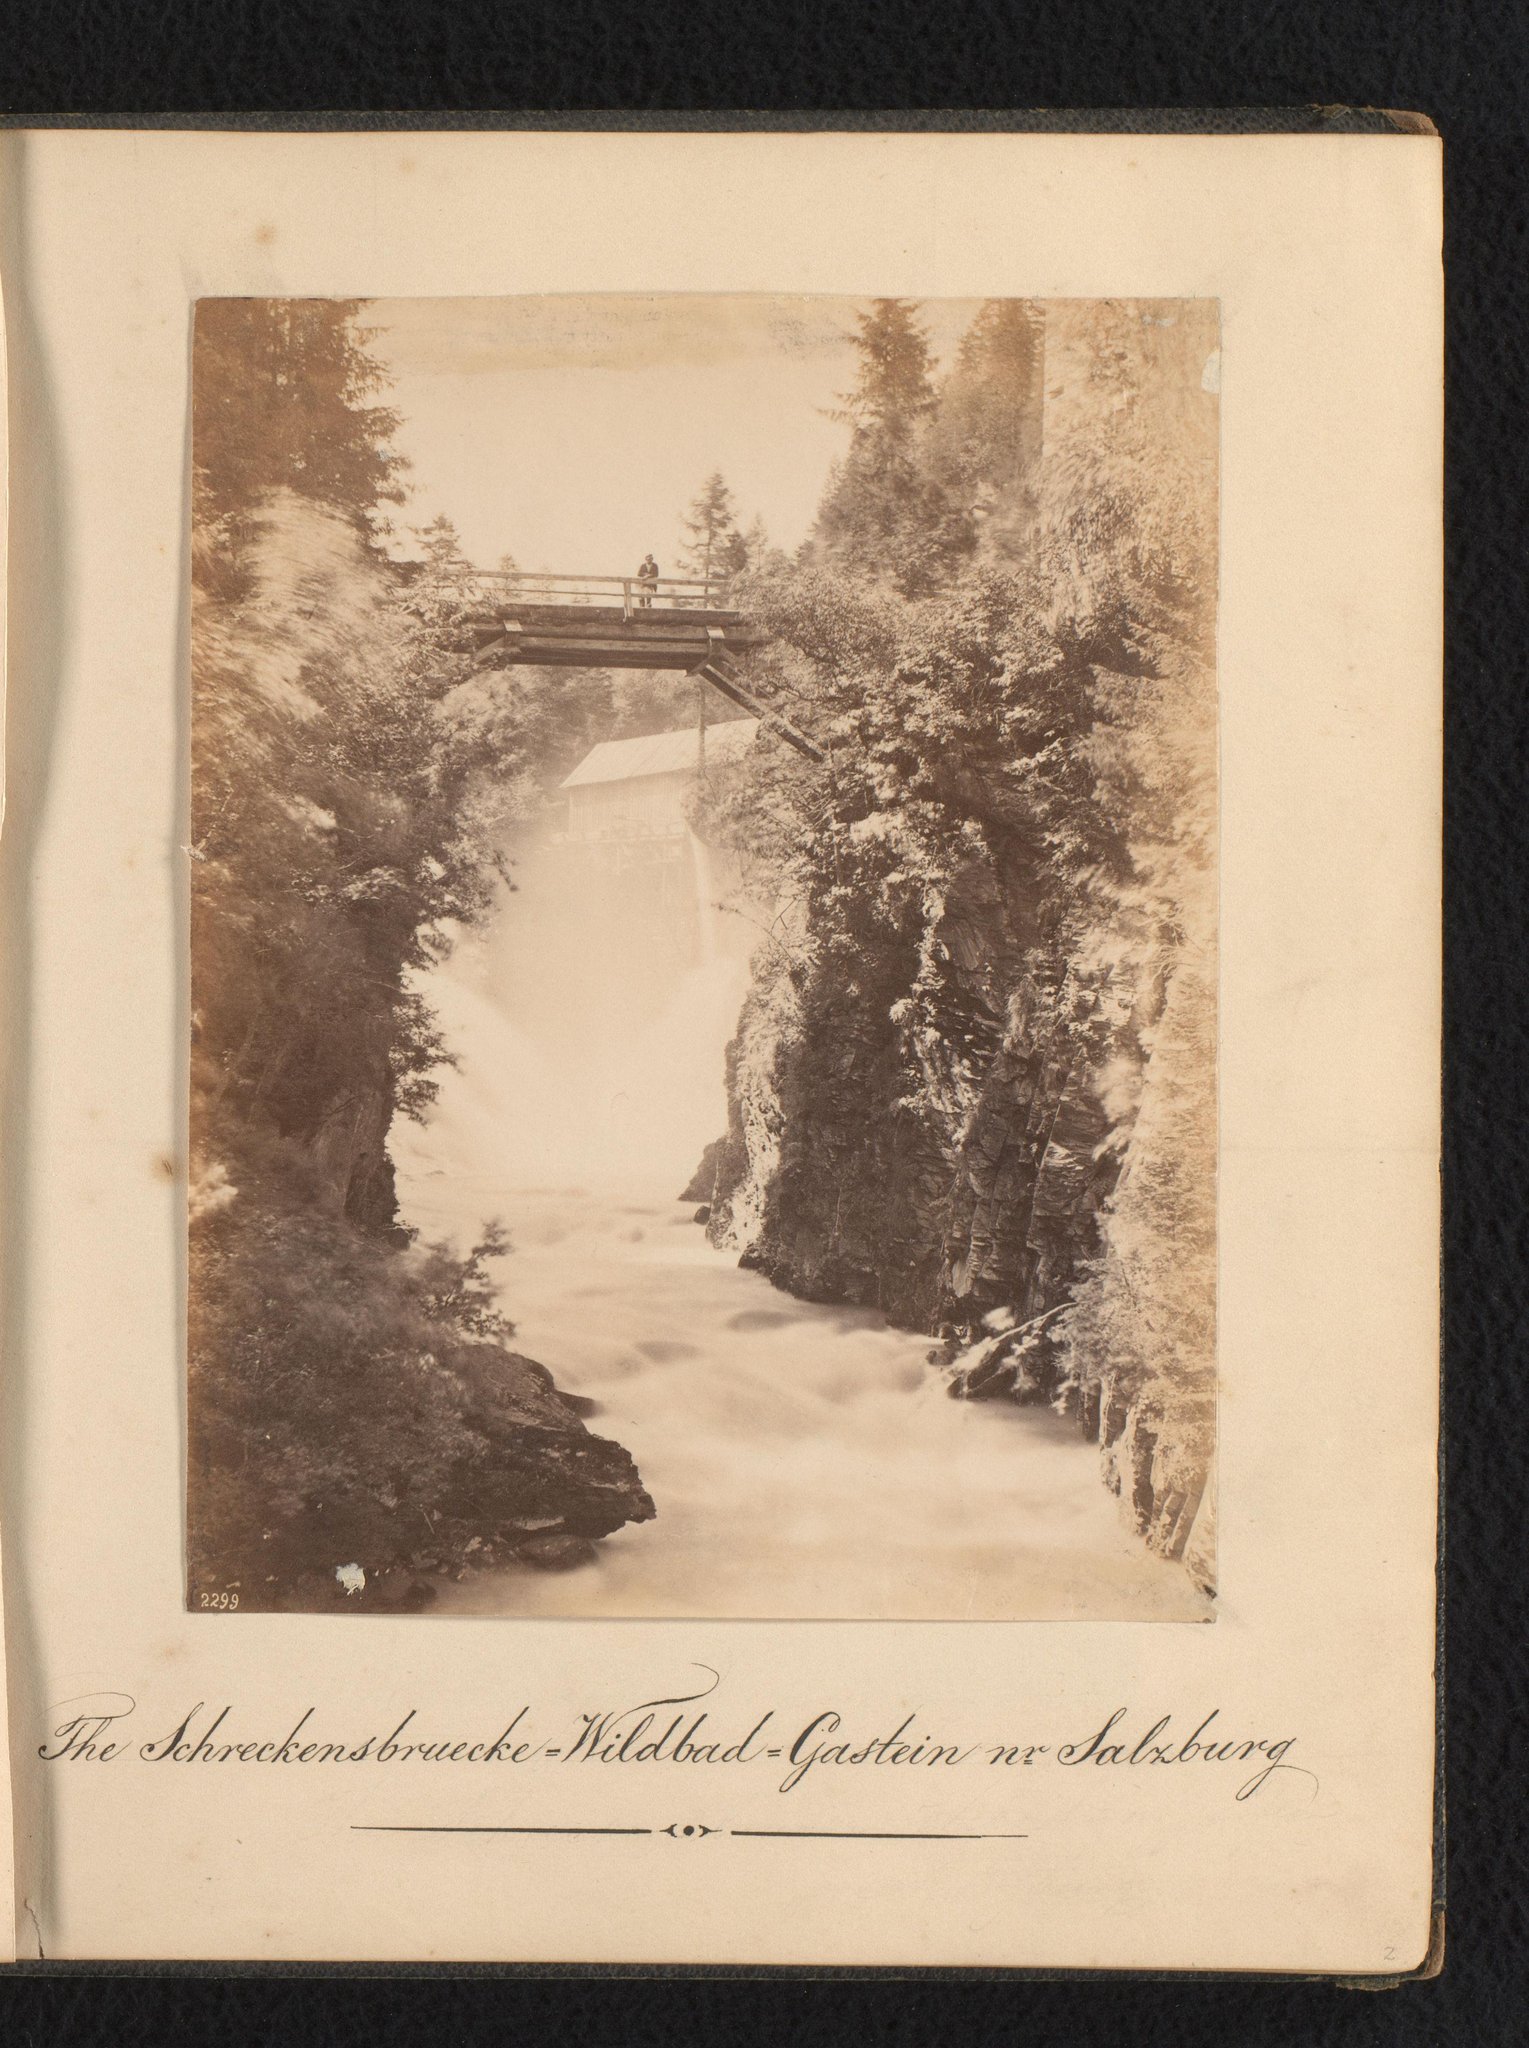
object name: photograph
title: Schreckensbrücke nabij Bad Gastein, Oostenrijk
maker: Anonymous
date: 1860-1870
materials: paper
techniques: albumen print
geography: bad gastein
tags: ravine, chasm, abyss, canyon, brook, bridge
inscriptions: number: ‘2299’